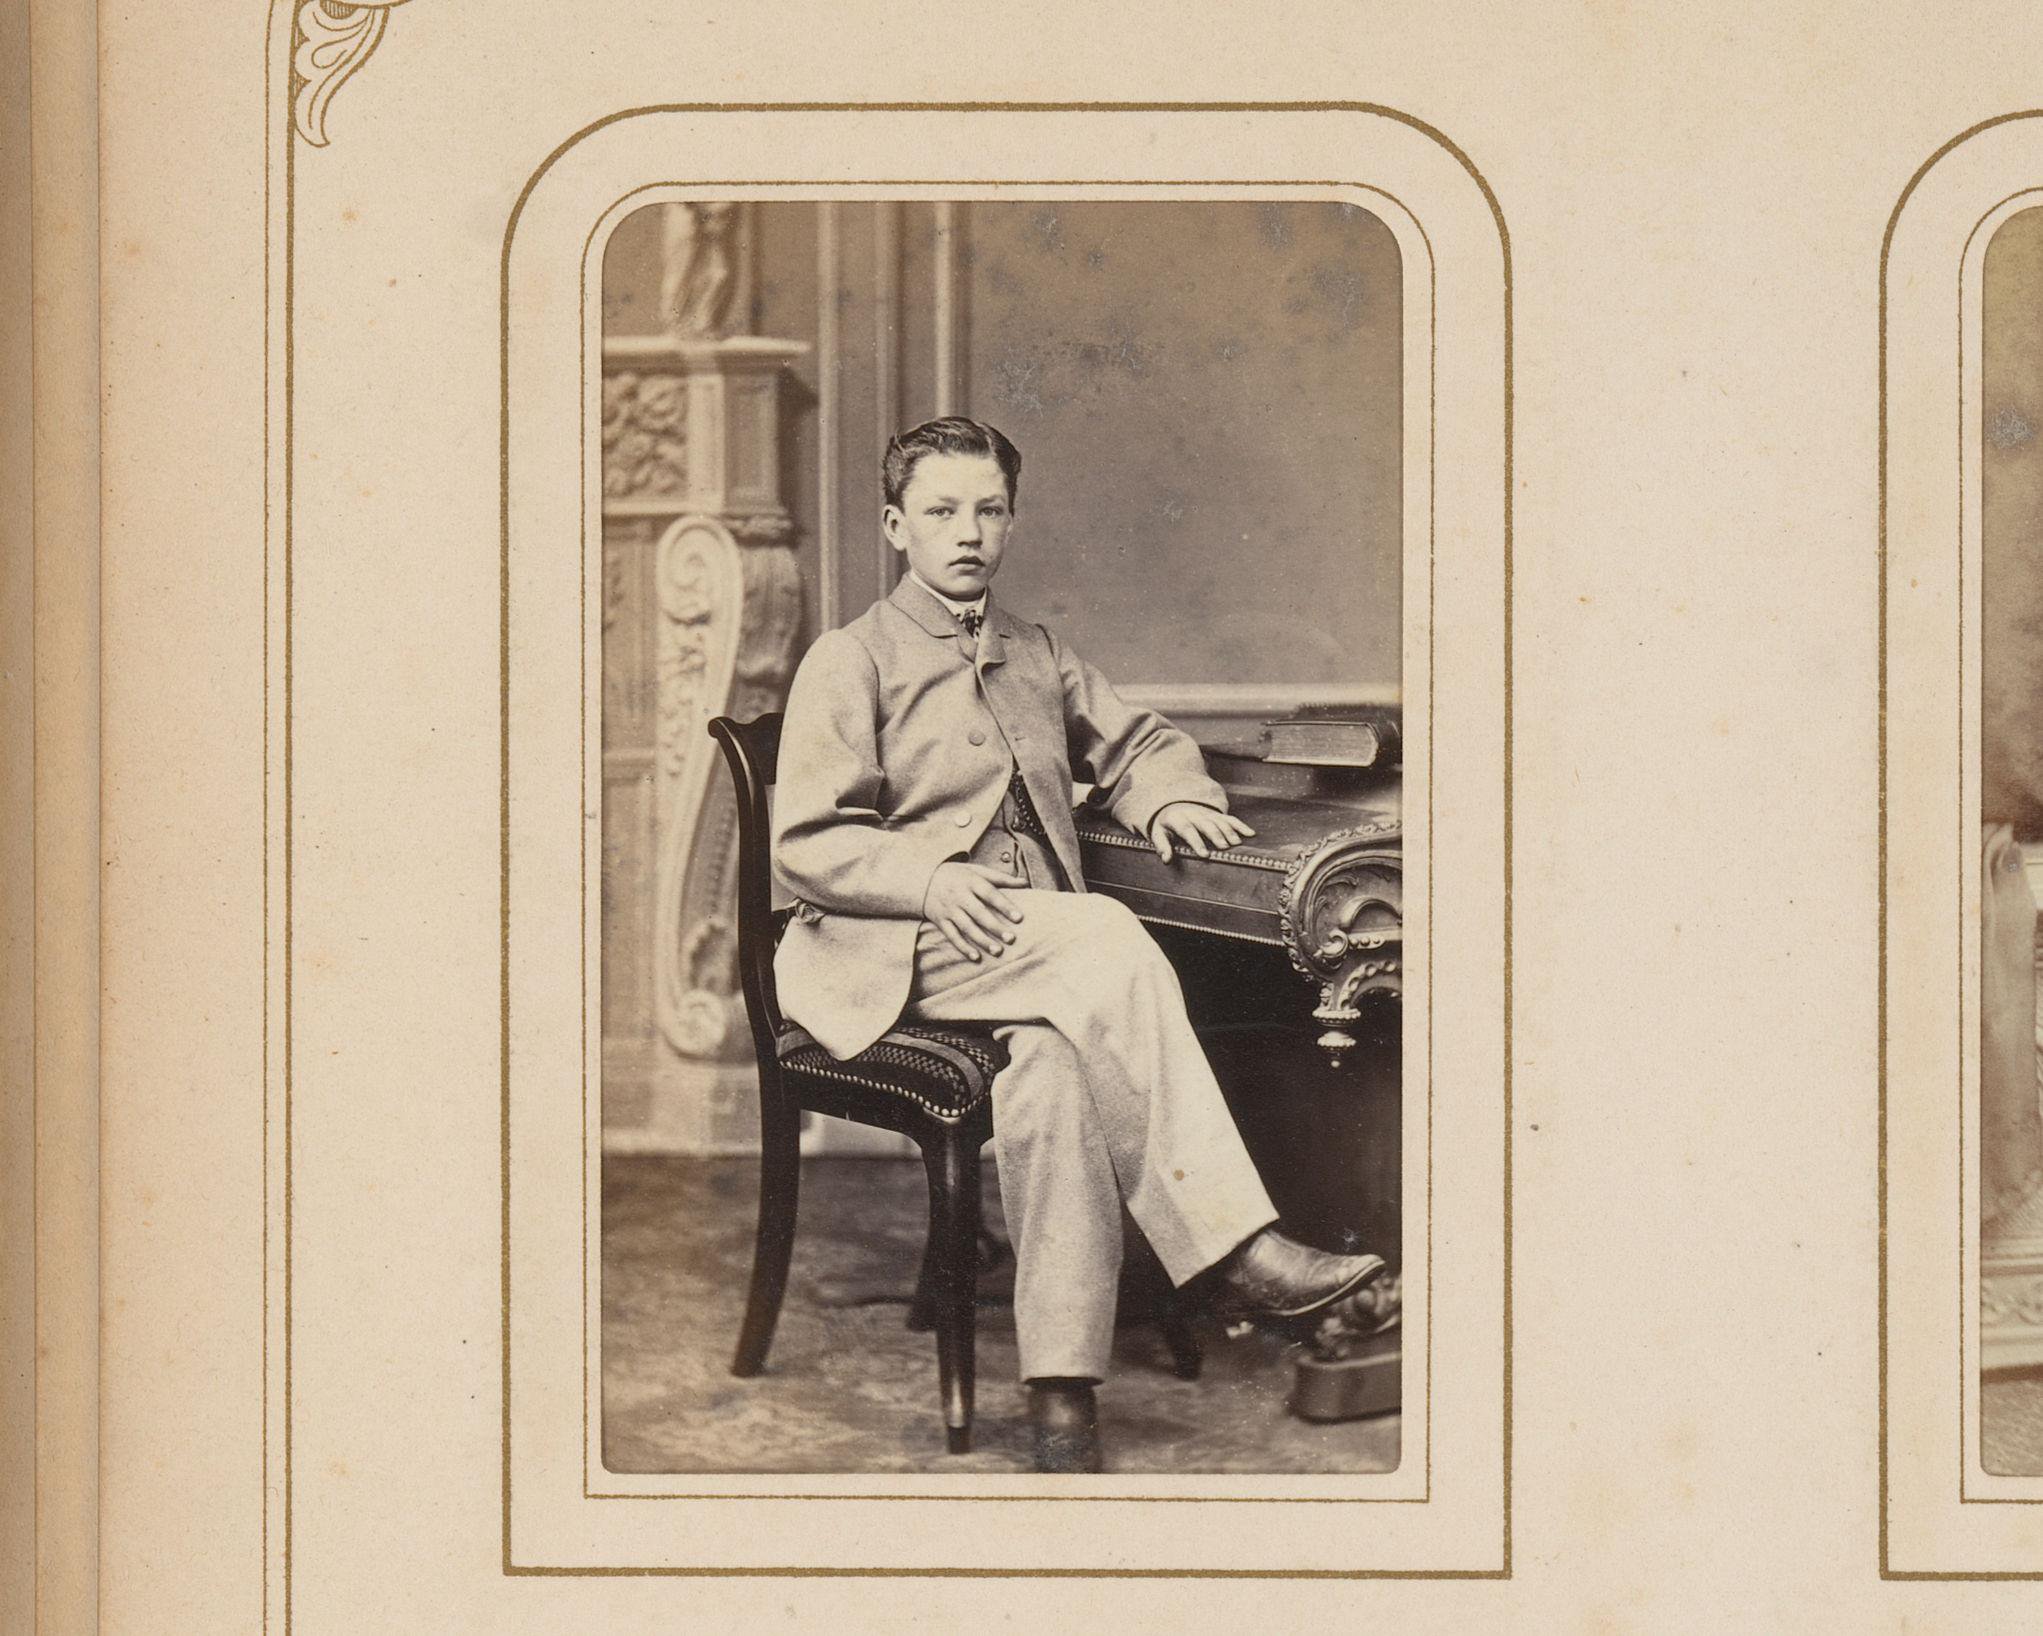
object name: carte de visite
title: Portret van een jongen, zittend op een stoel aan een schrijftafel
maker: eduard fuchs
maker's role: painter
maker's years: 1832-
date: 1859-1870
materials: cardboard, photographic support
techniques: albumen print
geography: leeuwarden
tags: writing-table, writing-desk, boy (child between toddler and youth), historical persons, chair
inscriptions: inscription: ‘Photographie/ E. Fuchs/ LEEUWARDEN.’